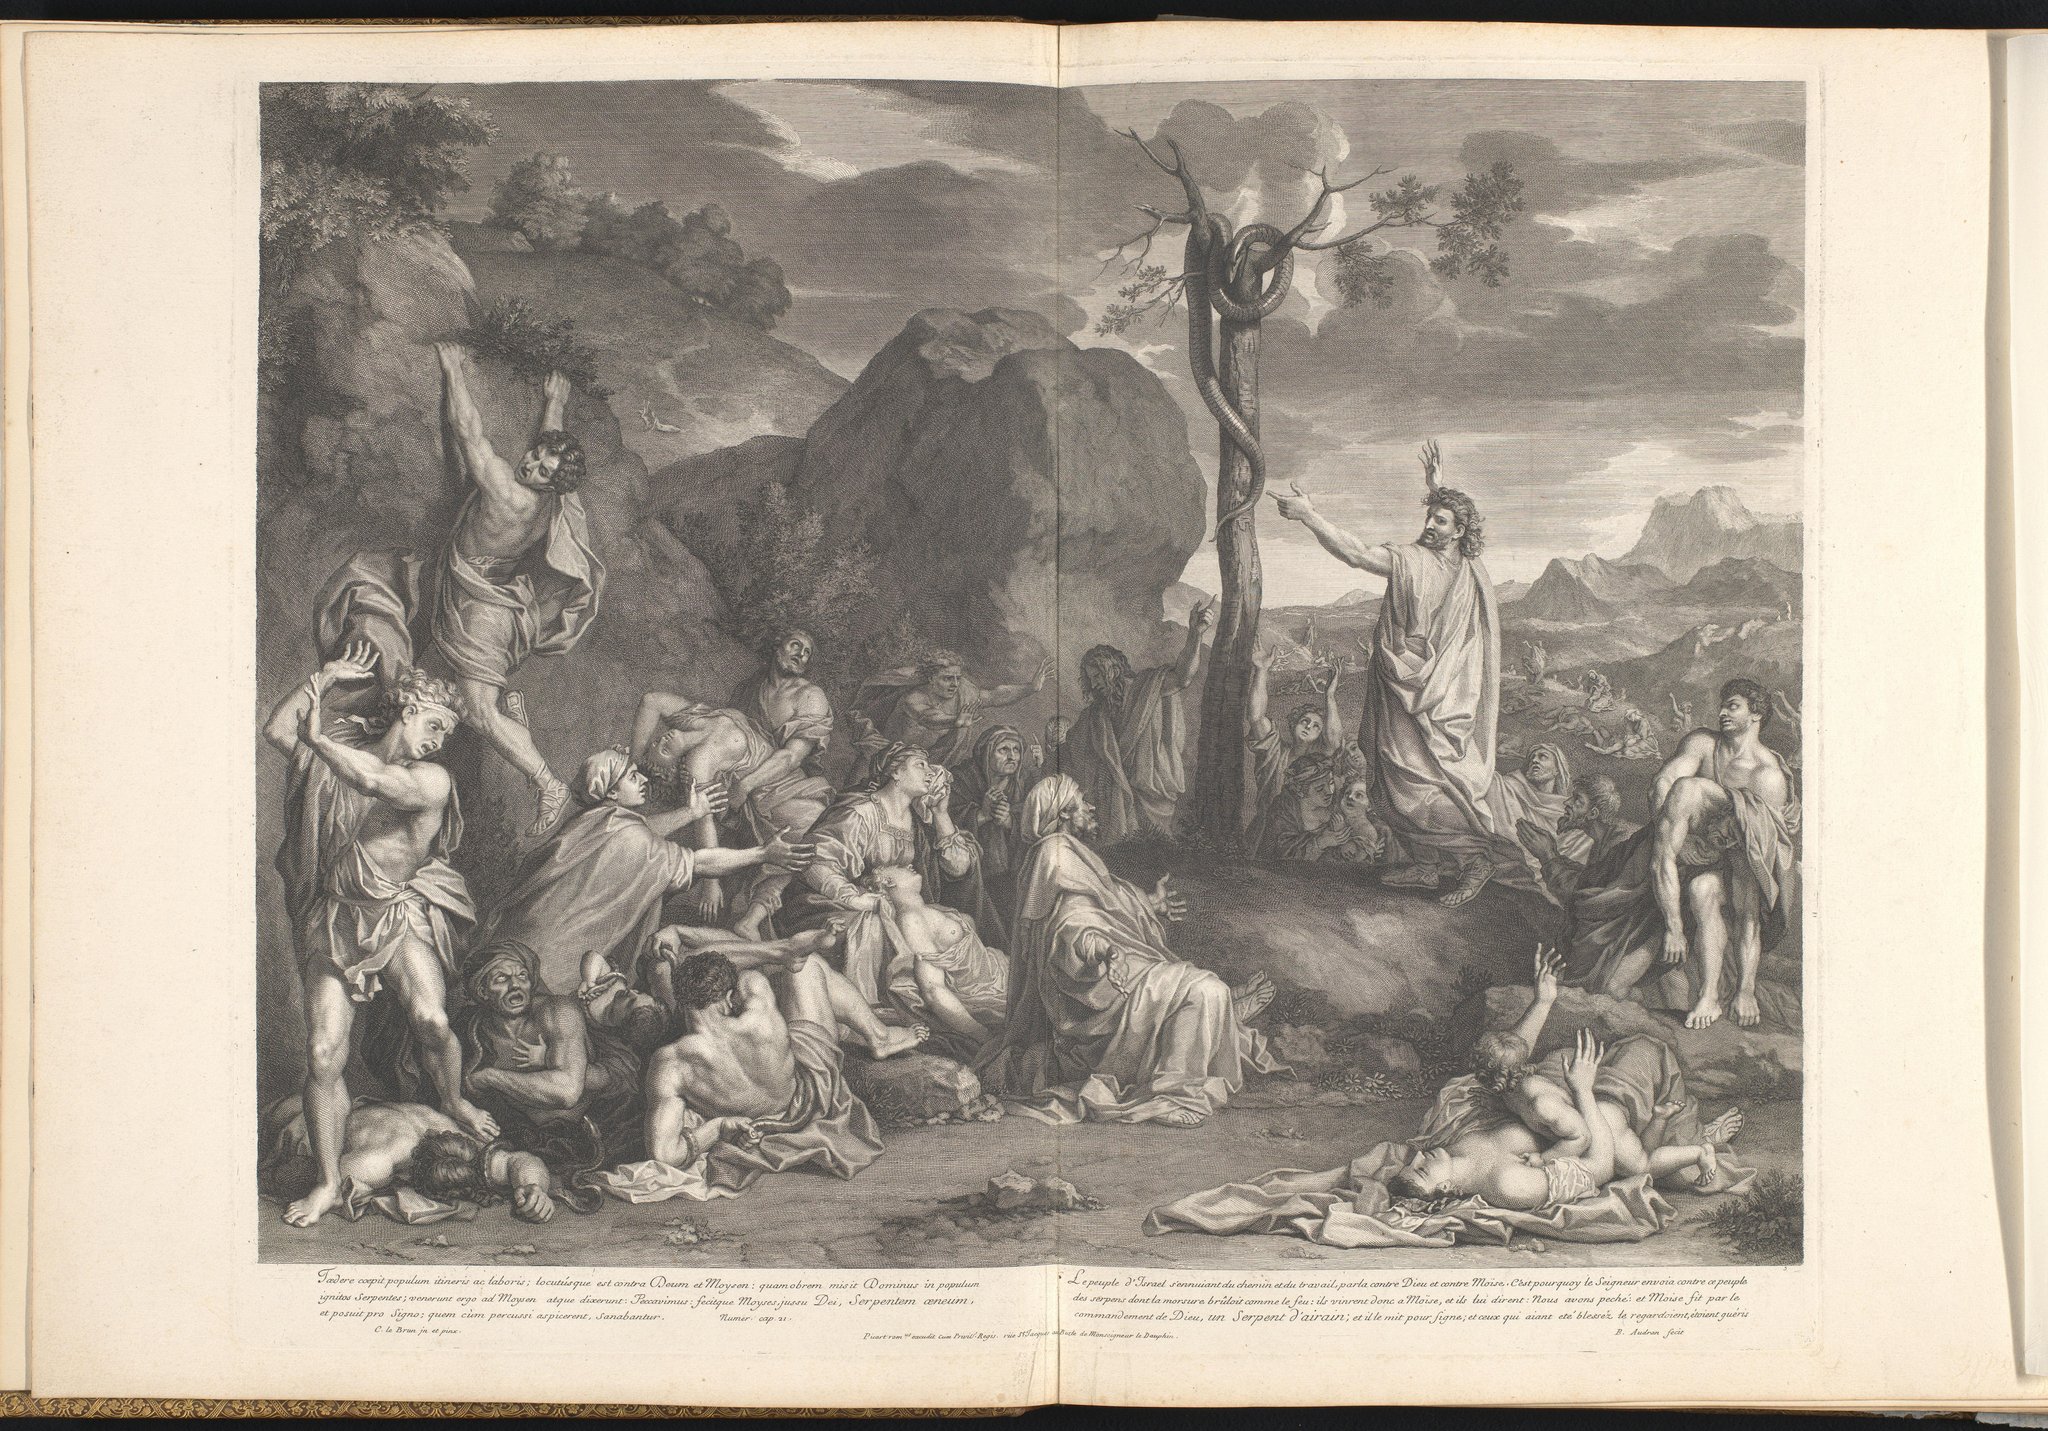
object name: print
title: Mozes en de Nehushtan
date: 1671-1721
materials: paper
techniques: engraving, etching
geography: paris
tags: the brazen serpent (numbers 21:4-9)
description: Numeri 21 en Johannes 3:14, het oprichten van de koperen slang. Deze prent maakt deel uit van een album.